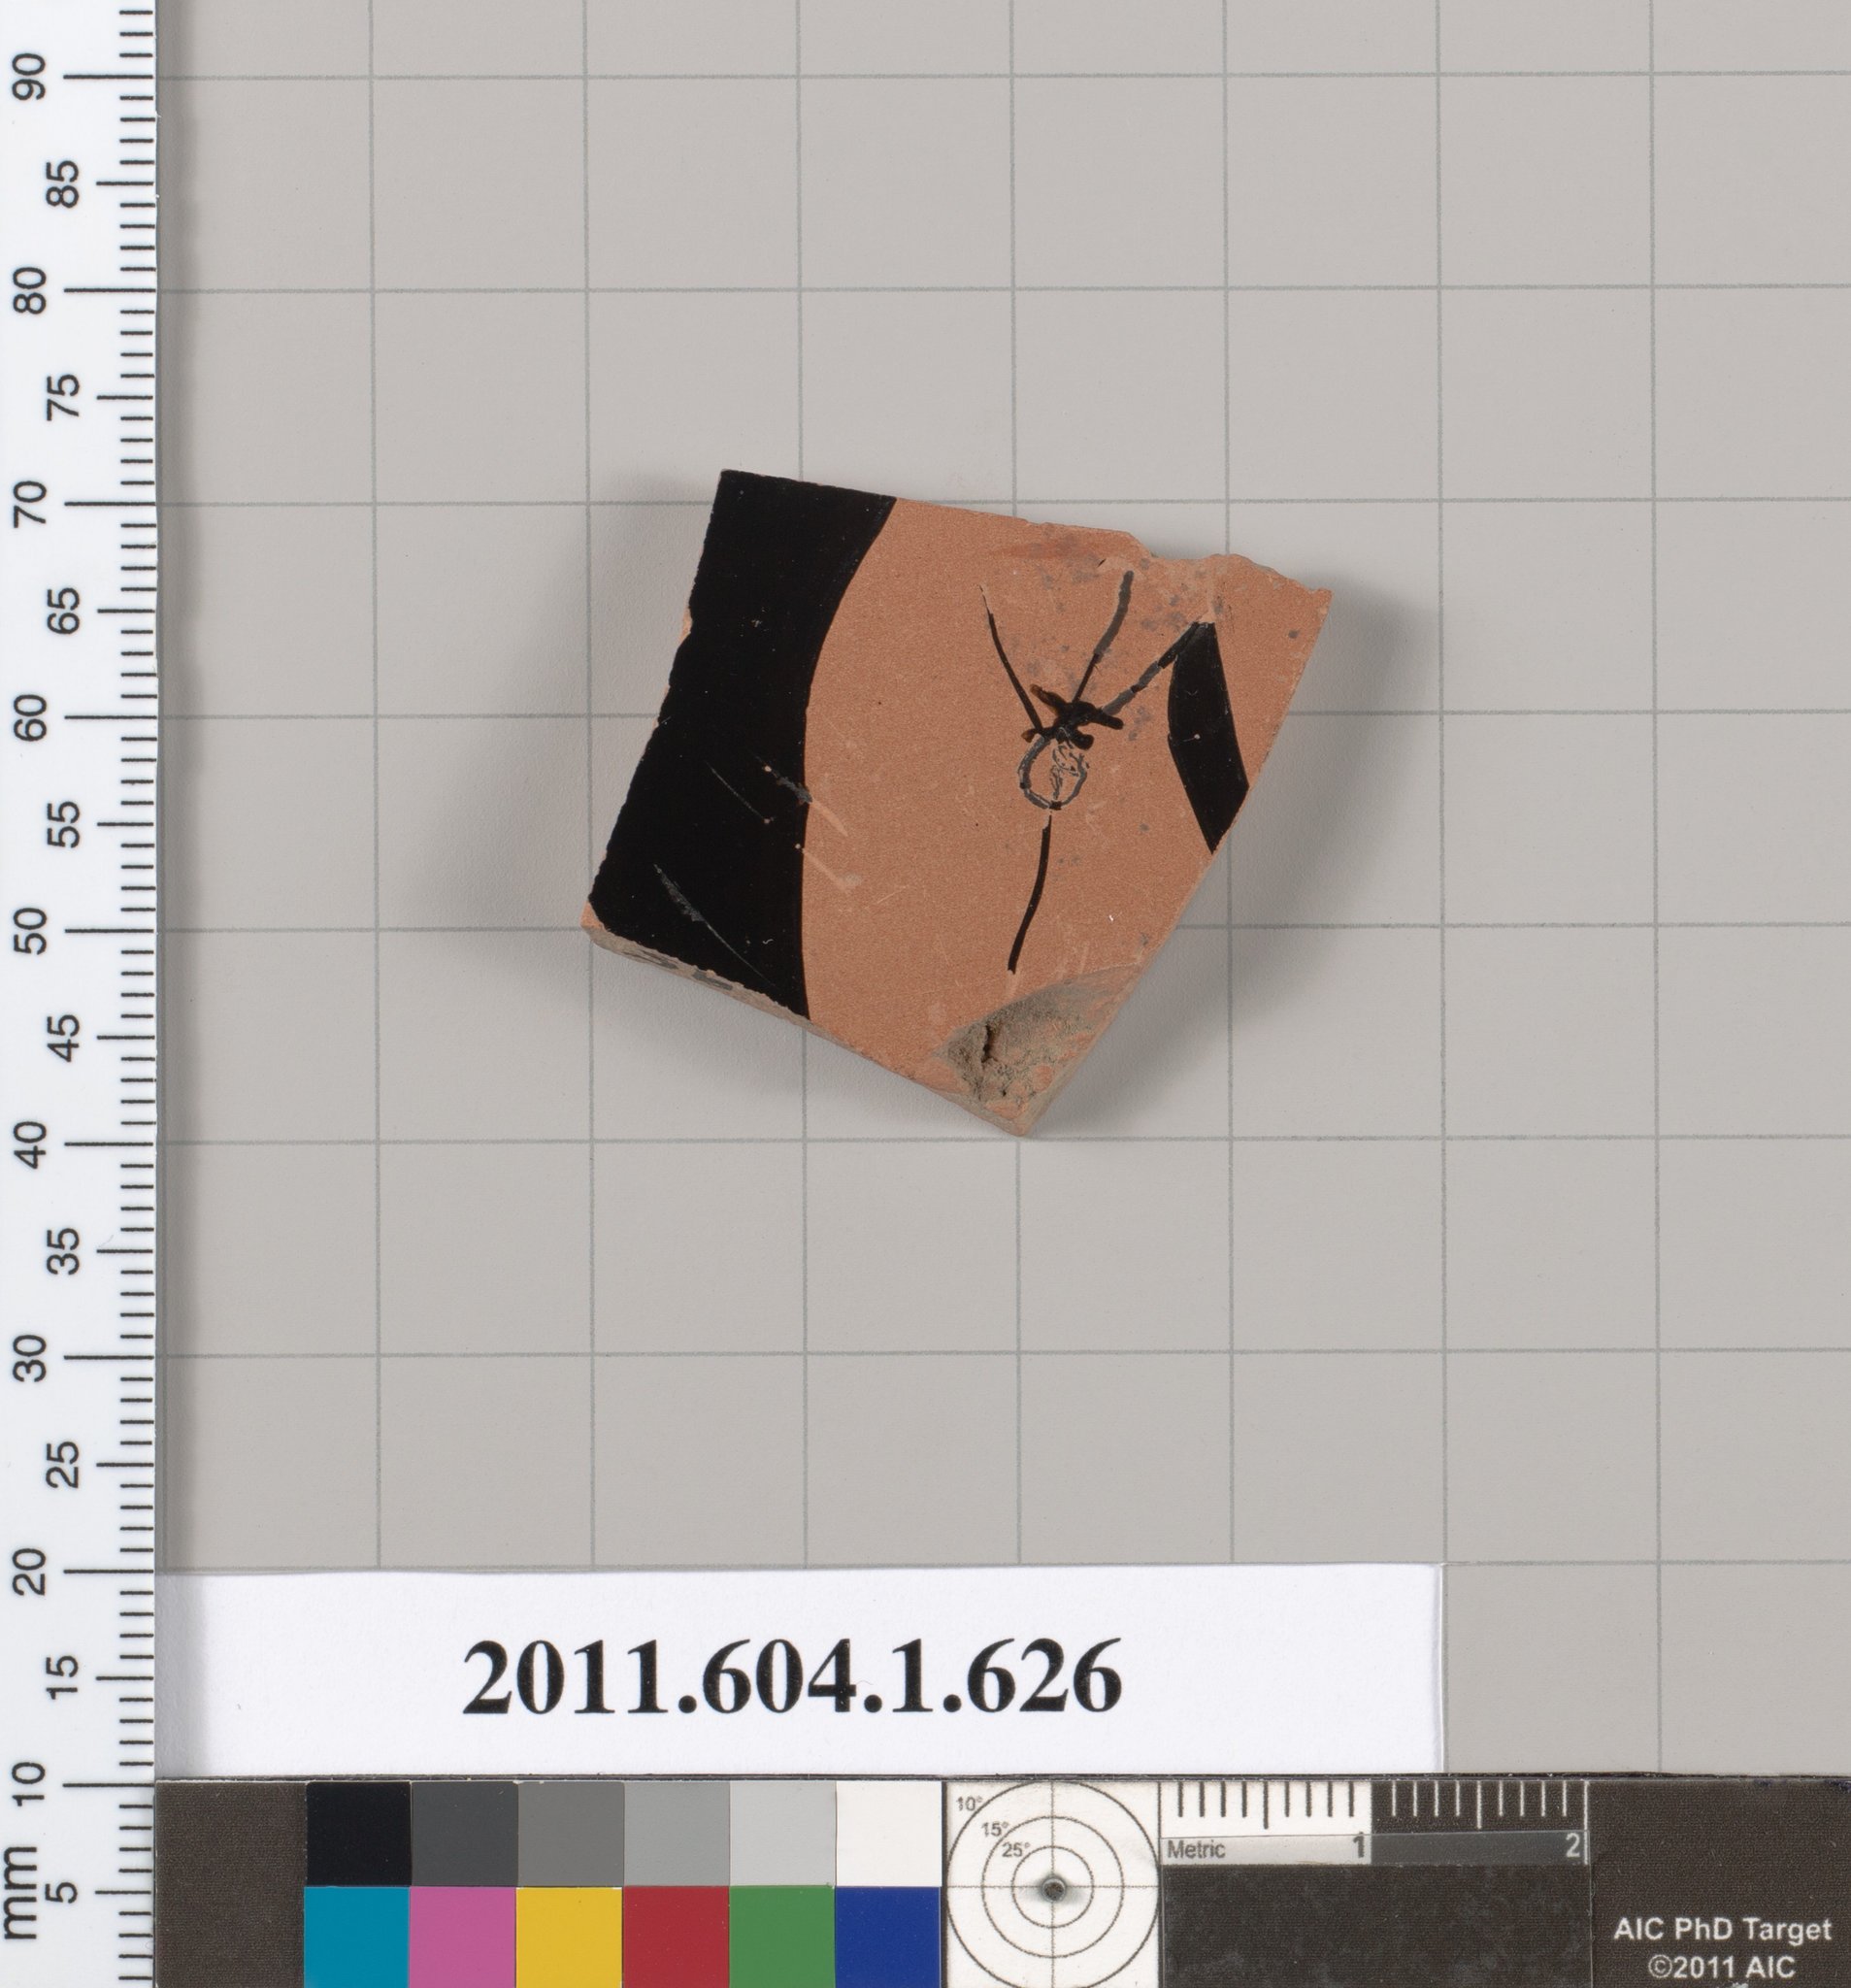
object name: kylix fragment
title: Terracotta fragment of a kylix (drinking cup)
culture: greek, attic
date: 475-451 BCE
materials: terracotta